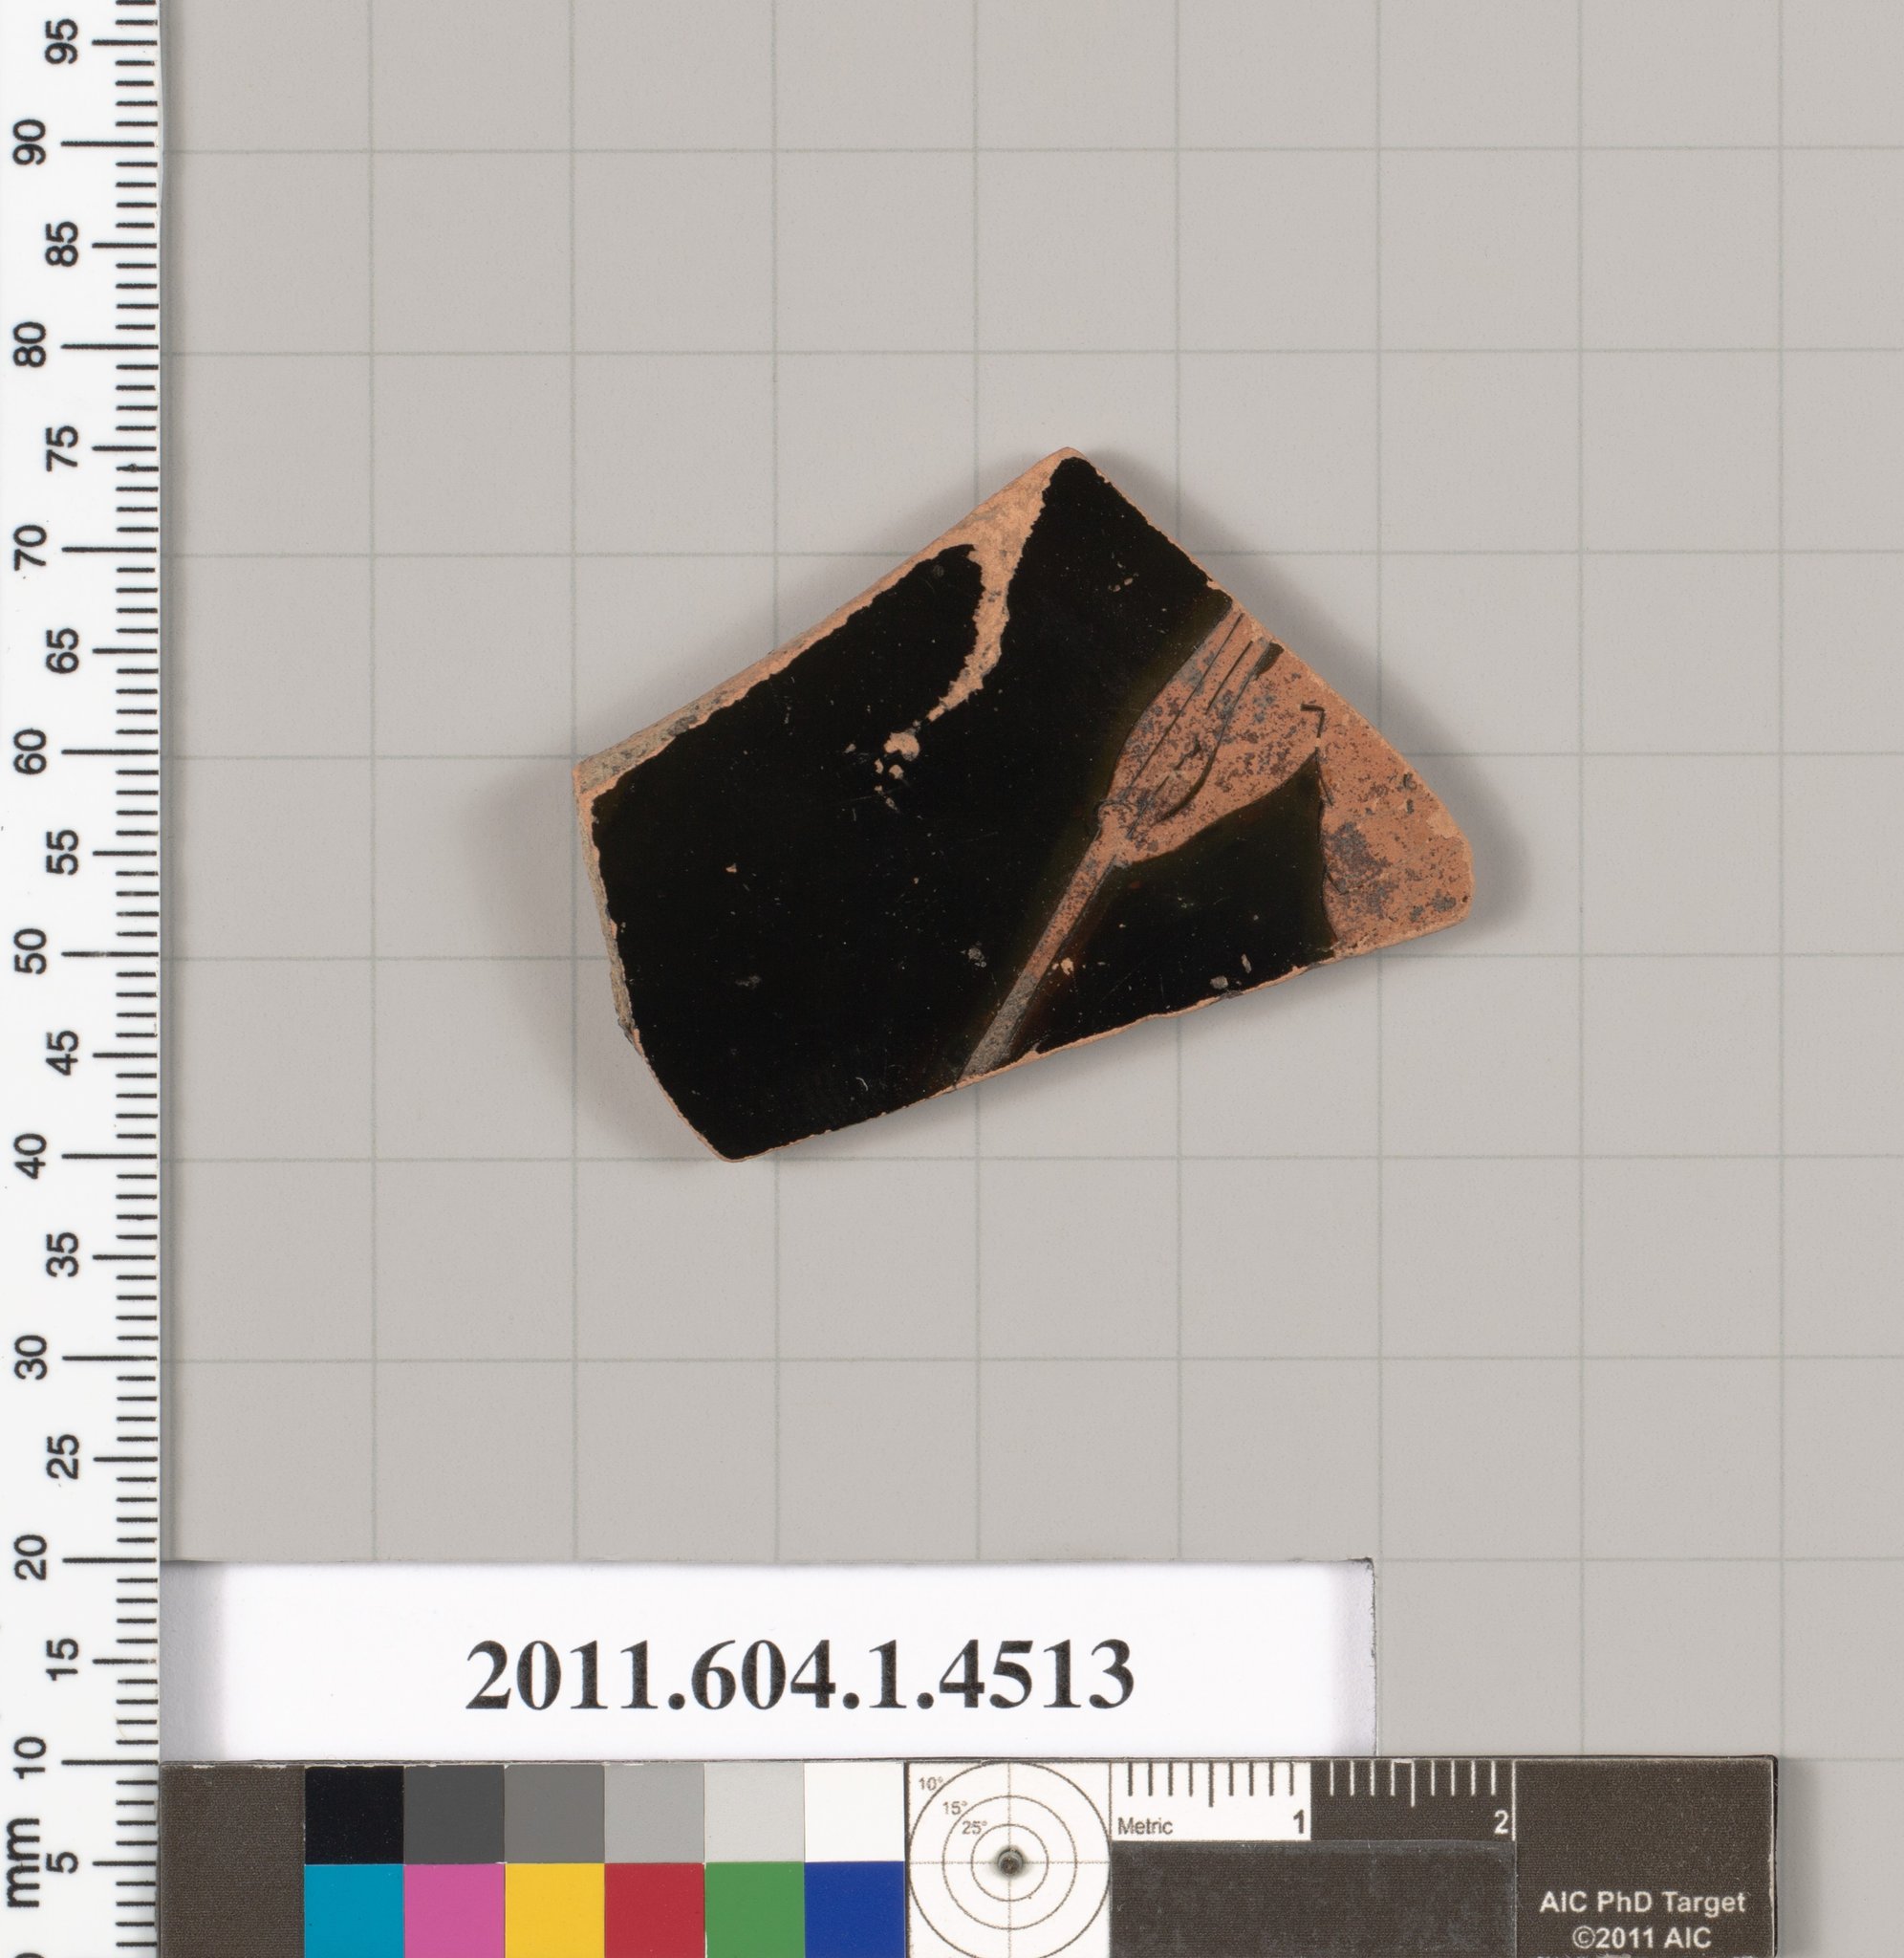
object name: kylix fragment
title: Terracotta fragment of a kylix (drinking cup)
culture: greek, attic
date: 475-451 BCE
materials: terracotta